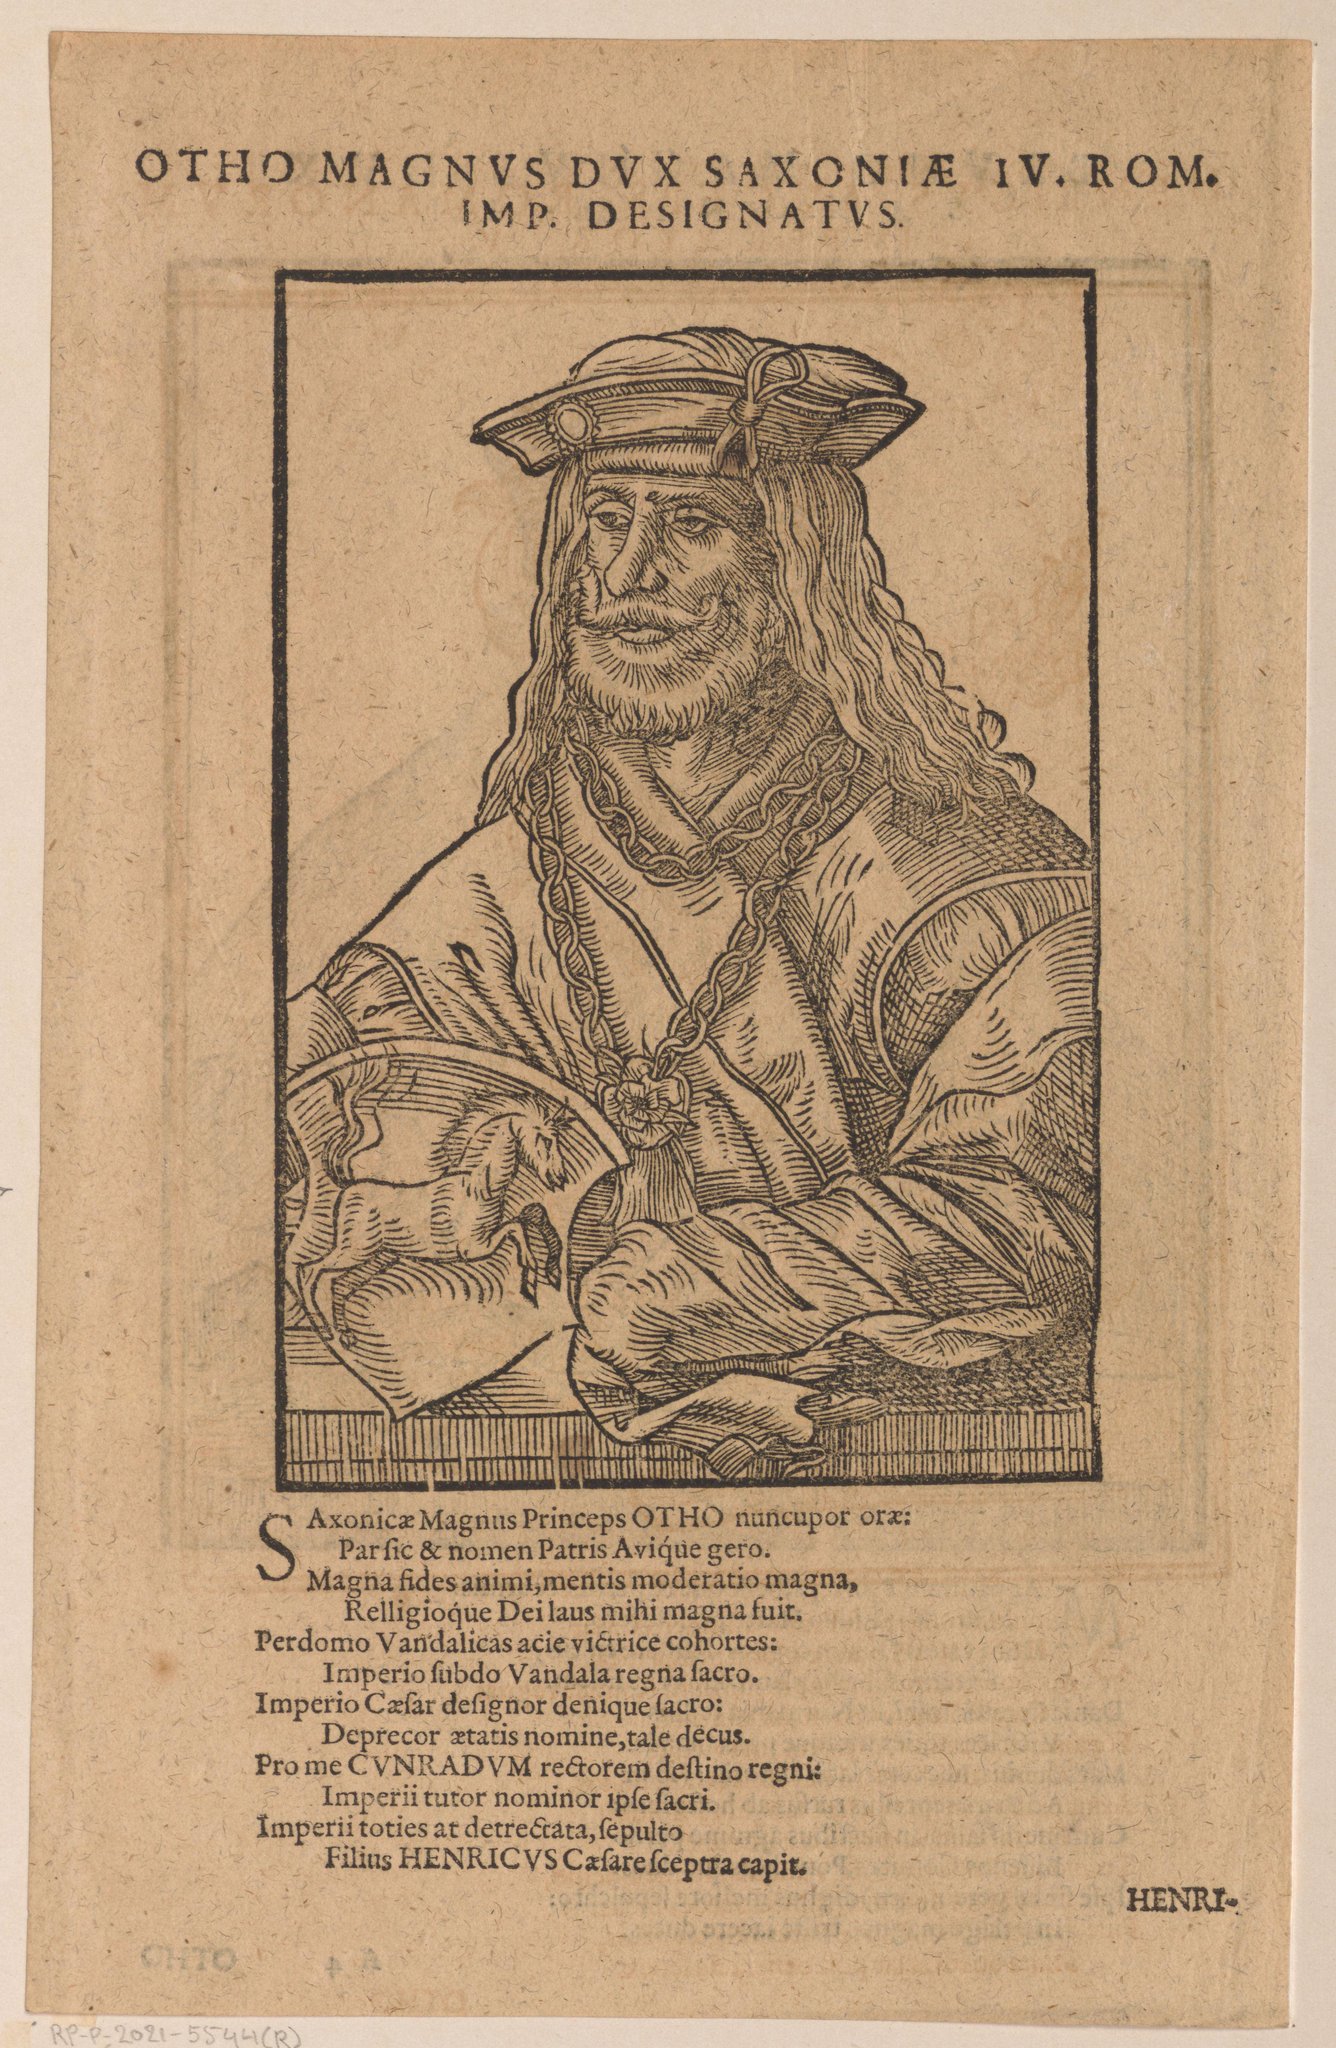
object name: book illustration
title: Portret van Otto IV, keizer van het Heilige Roomse Rijk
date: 1597-1610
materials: paper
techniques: letterpress printing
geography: leipzig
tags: historical persons, armorial bearing, heraldry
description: Prent uit: Reusner, Elias. Genealogiae regum electorum ducum (...). Leipzig: Henning Grosse I, 1610. Of een eerdere publicatie (1597).